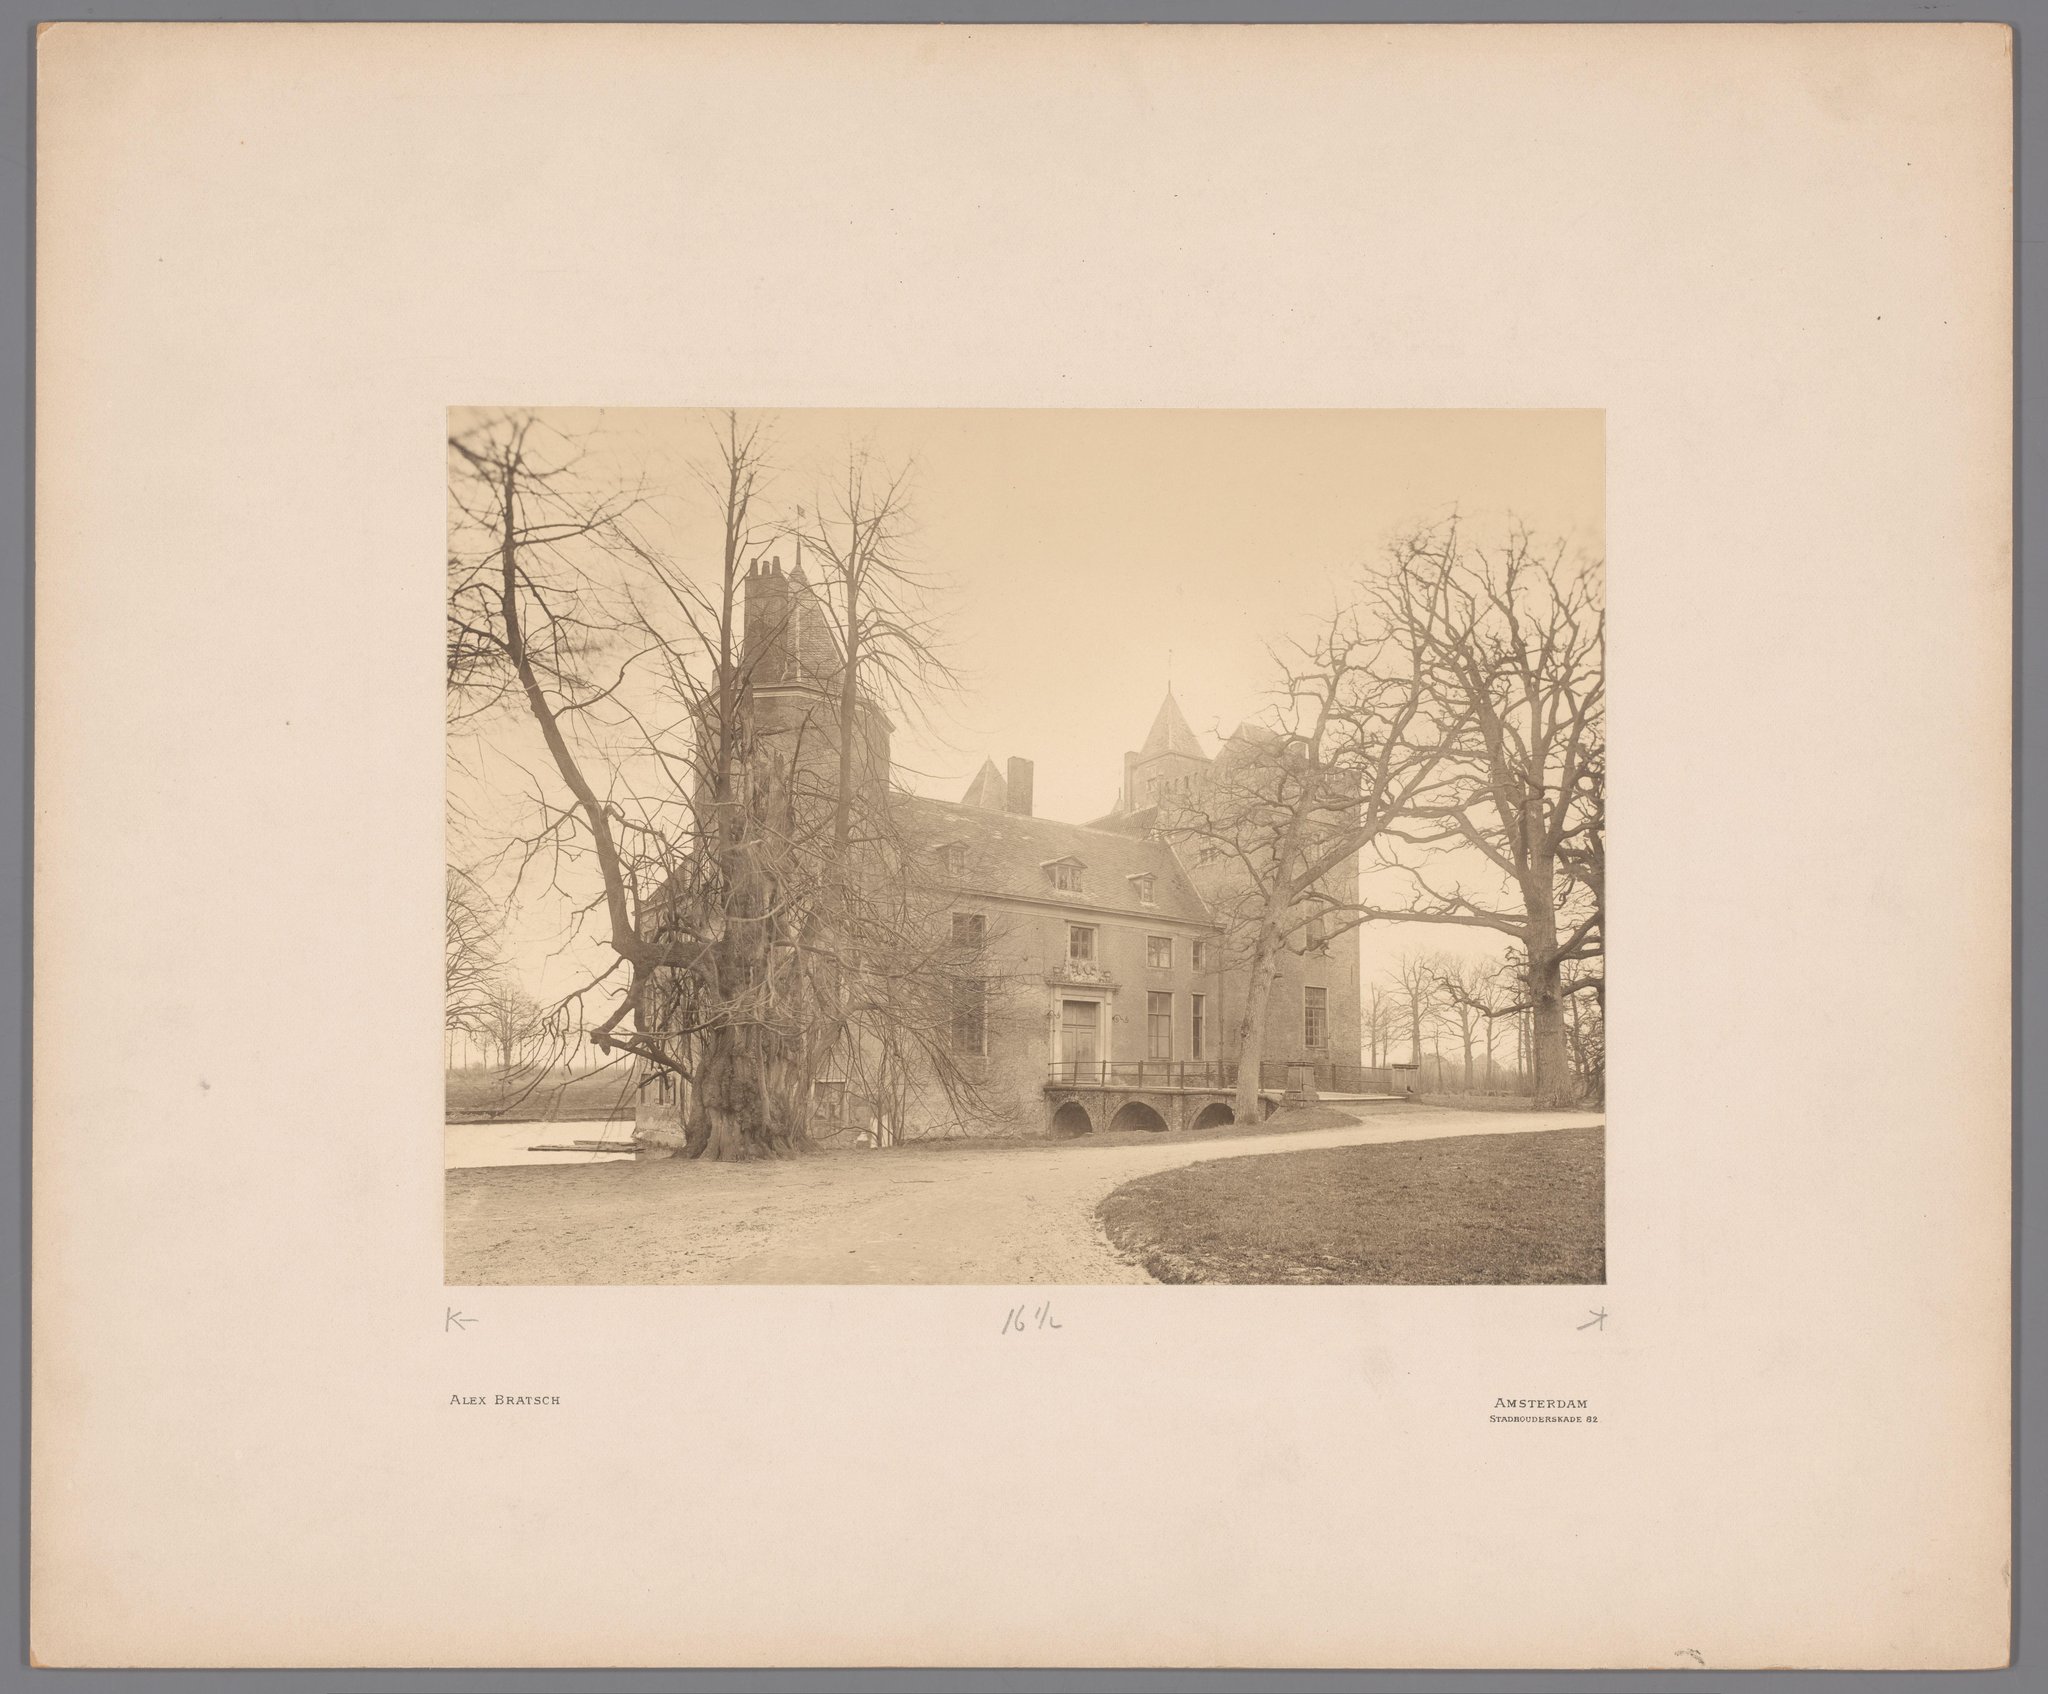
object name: photograph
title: Slot Assumburg bij Heemskerk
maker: alex bratsch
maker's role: fotograaf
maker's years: 1869-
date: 1910-1930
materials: cardboard, photographic support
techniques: gelatin silver print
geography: heemskerk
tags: castle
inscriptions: number: ‘118’, annotation: ‘Assumburg - Heemskerk NH/ Assendelft/ No 1’, annotation: ‘16 1/2’, inscription: ‘Amsterdam/ Stadhouderskade 82’